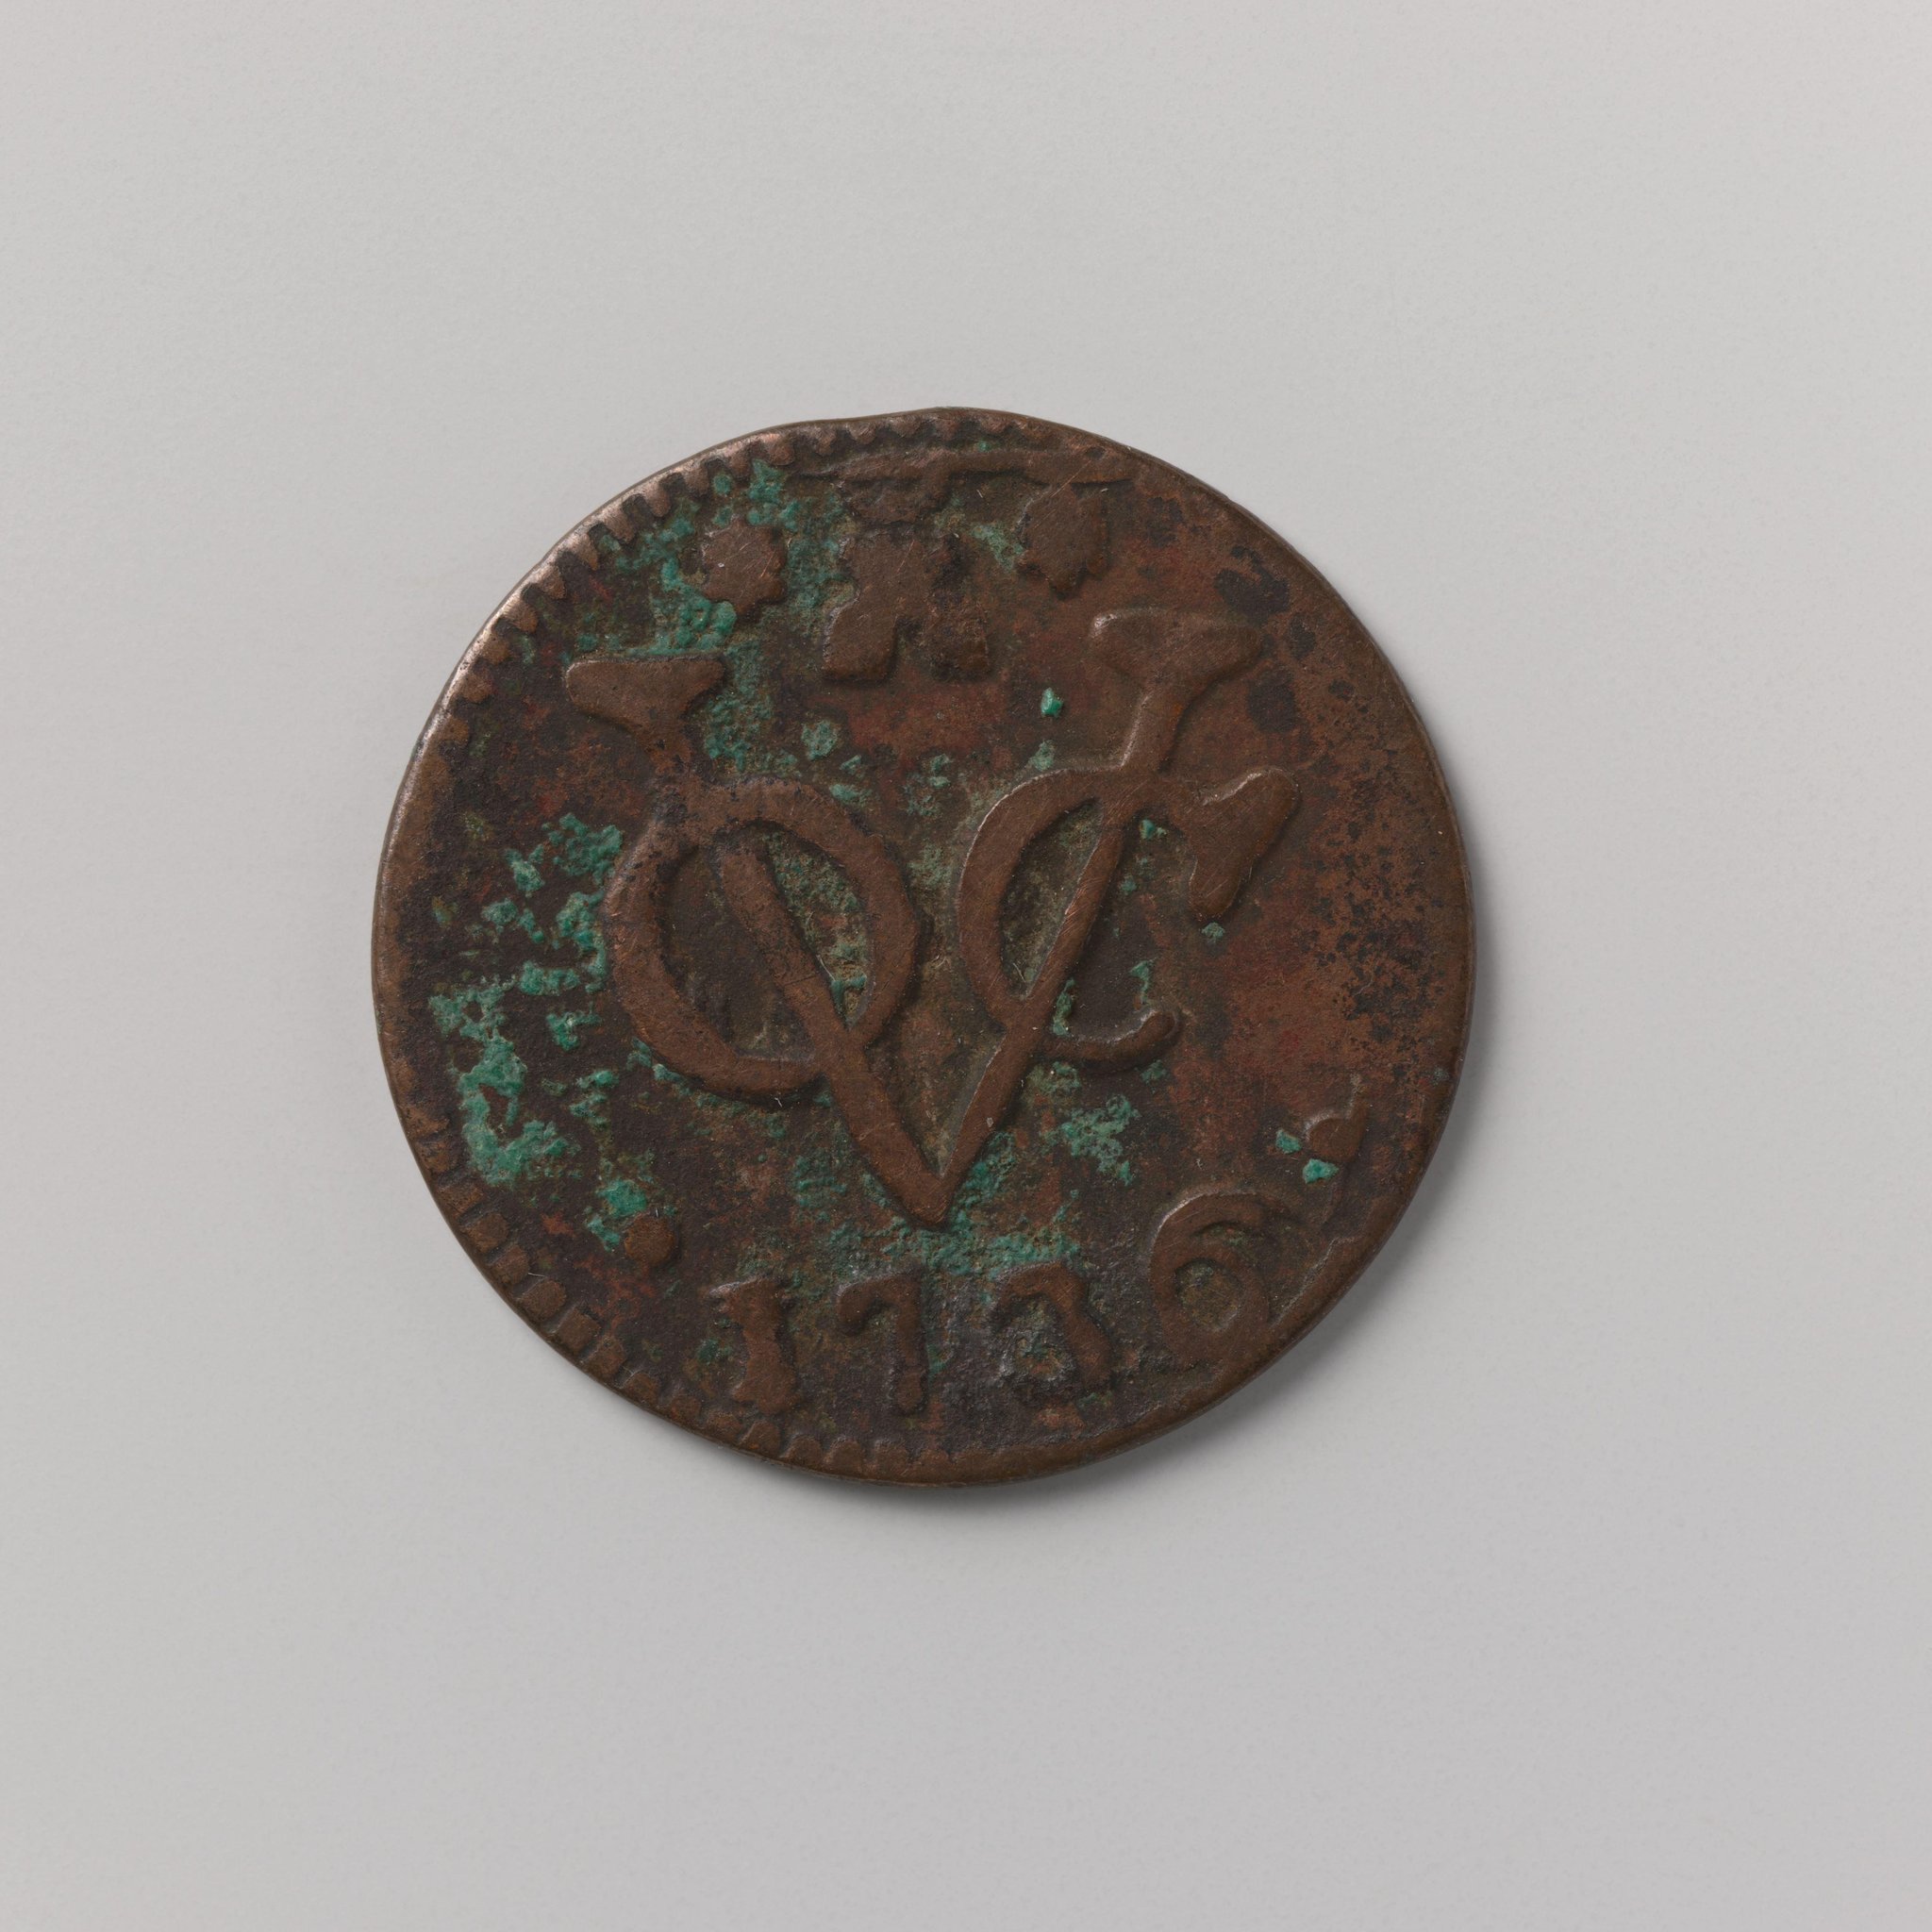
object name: coin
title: Duit van de VOC uit Zeeland, 1736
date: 1736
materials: copper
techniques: striking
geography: middelburg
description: Koperen munt. Voorzijde: gekroond wapenschild van Zeeland. Keerzijde: monogram van de VOC, waarboven muntteken en waaronder jaartal. Gladde rand.